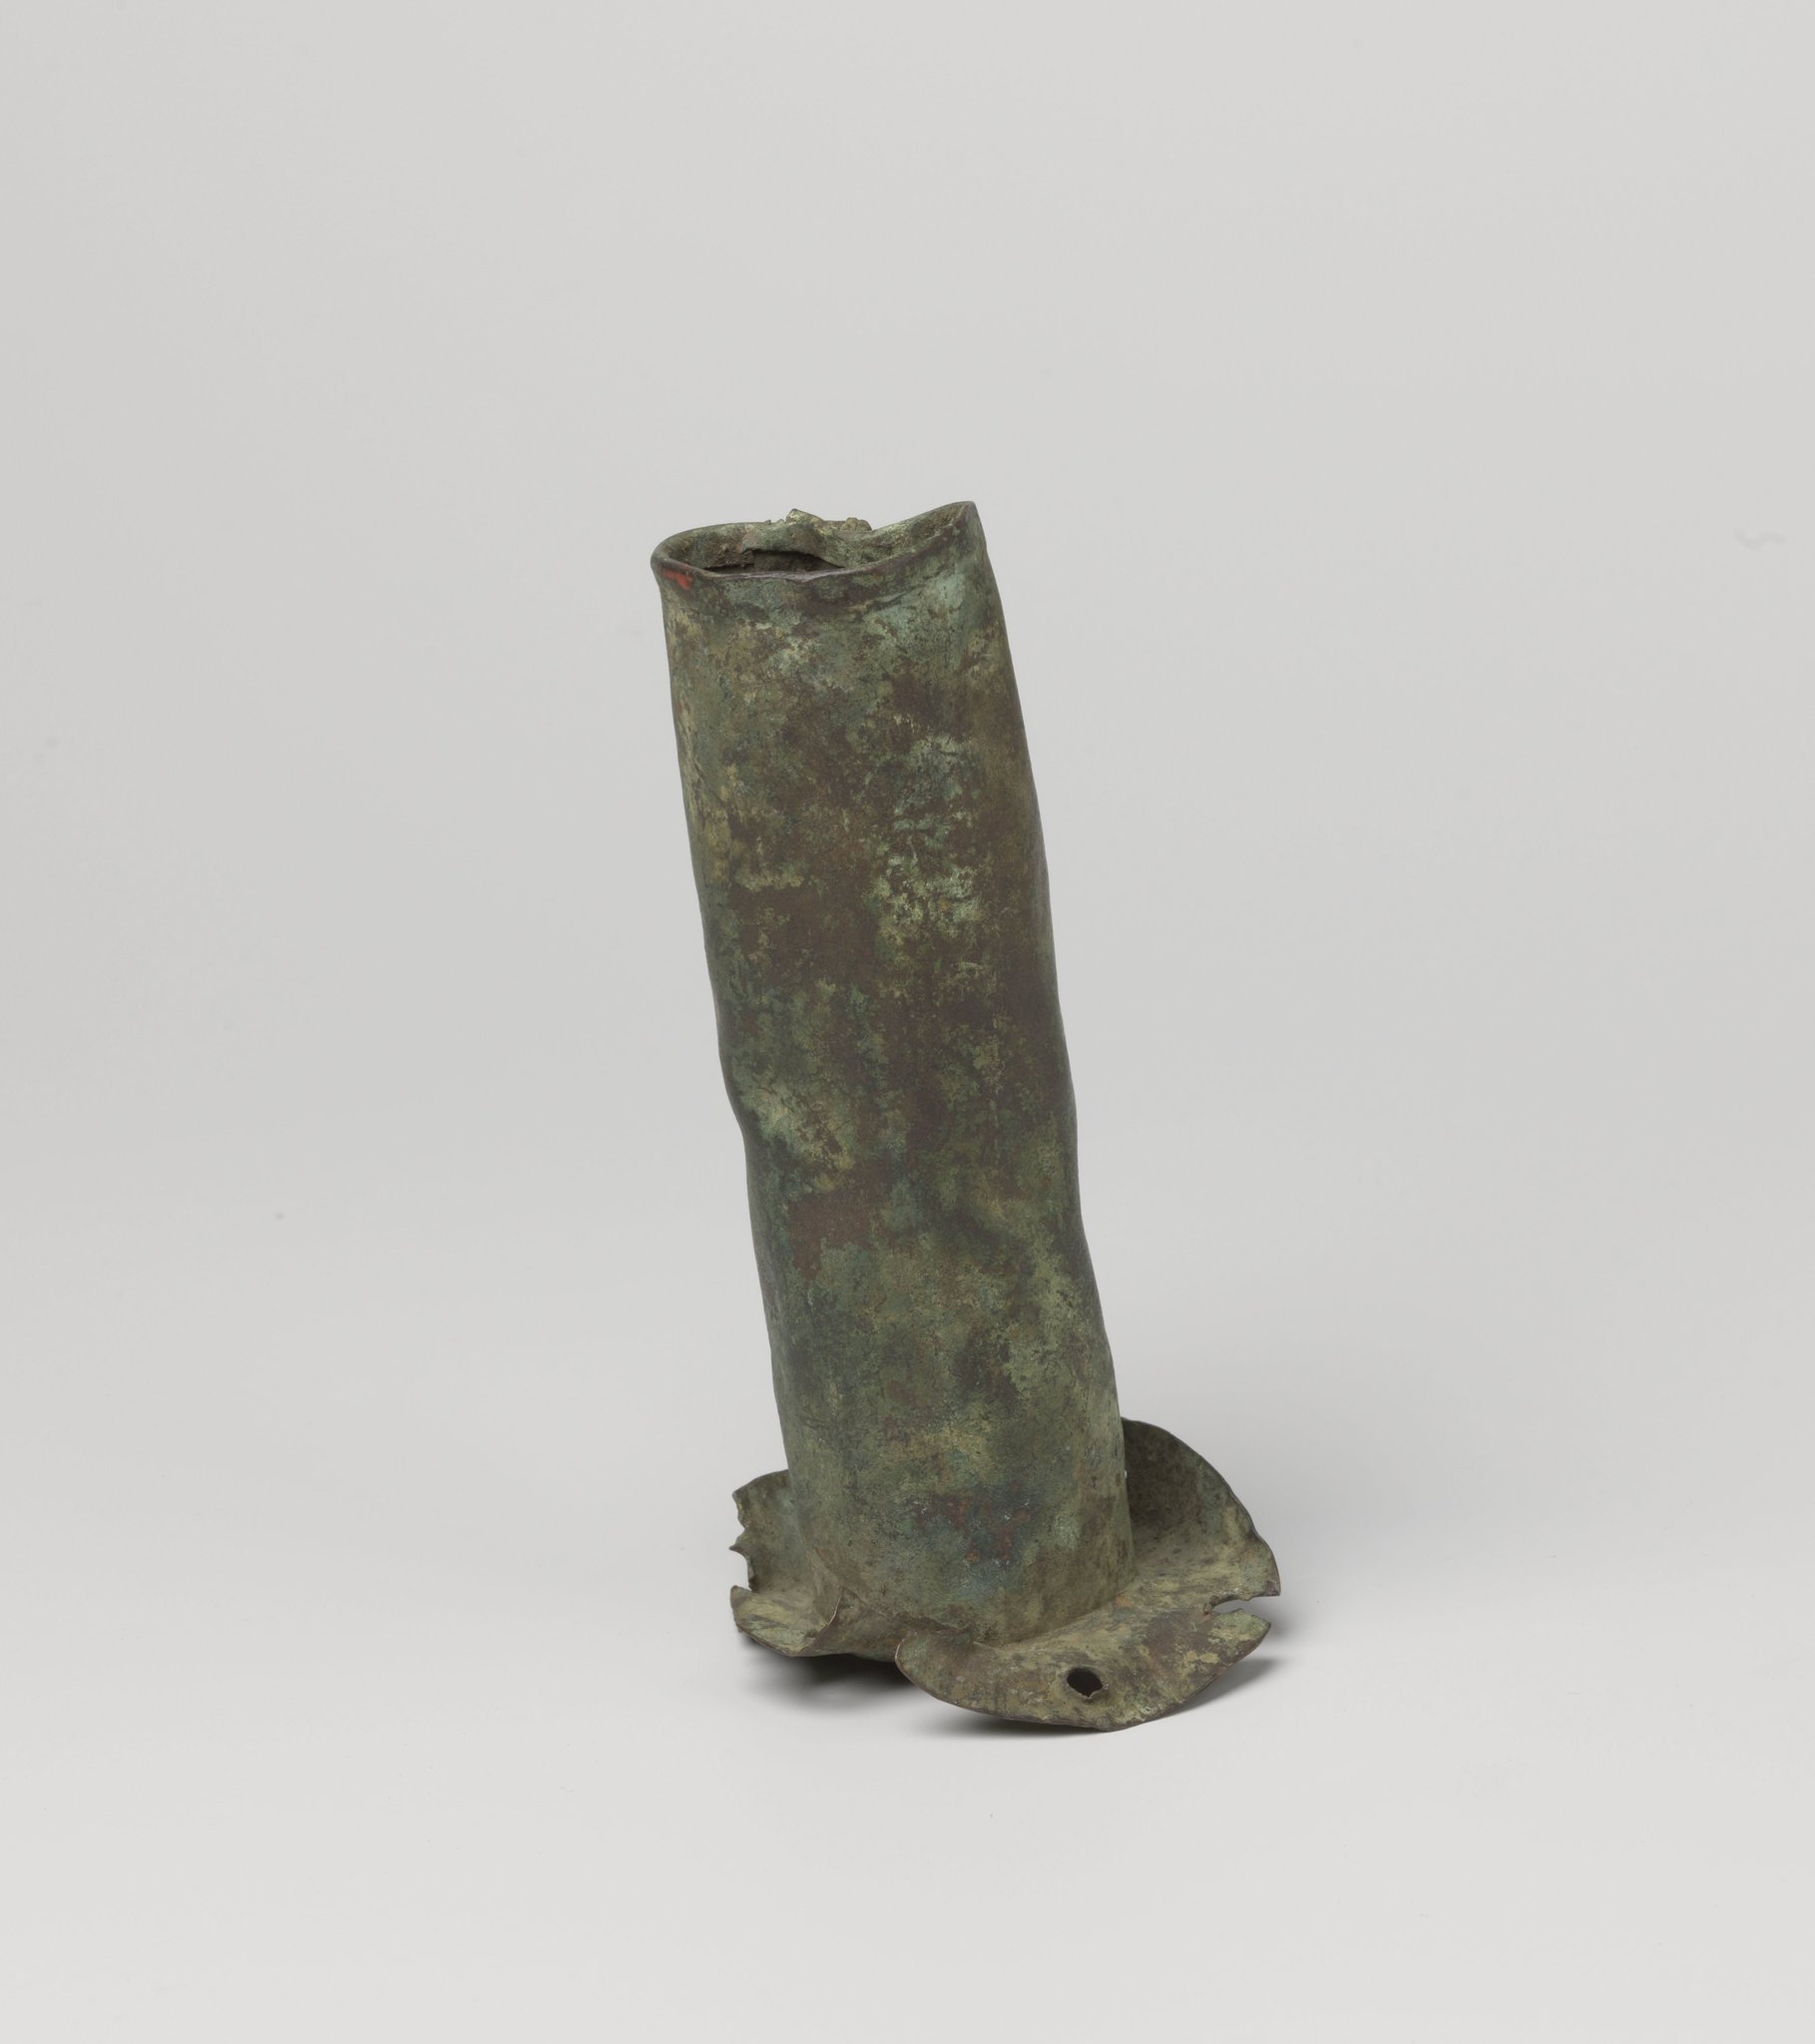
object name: drain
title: Afvoerbuis met een 'bevestigingsring' met vijf gaten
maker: Anonymous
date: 1590-1596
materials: copper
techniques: striking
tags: willem barendsz., amsterdam, jacob van heemskerck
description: Afvoerbuis met aan een uiteinde een 'bevestigingsring' met vijf gaten voor spijkers of schroeven. Oorspronkelijk ronde buis met naad.